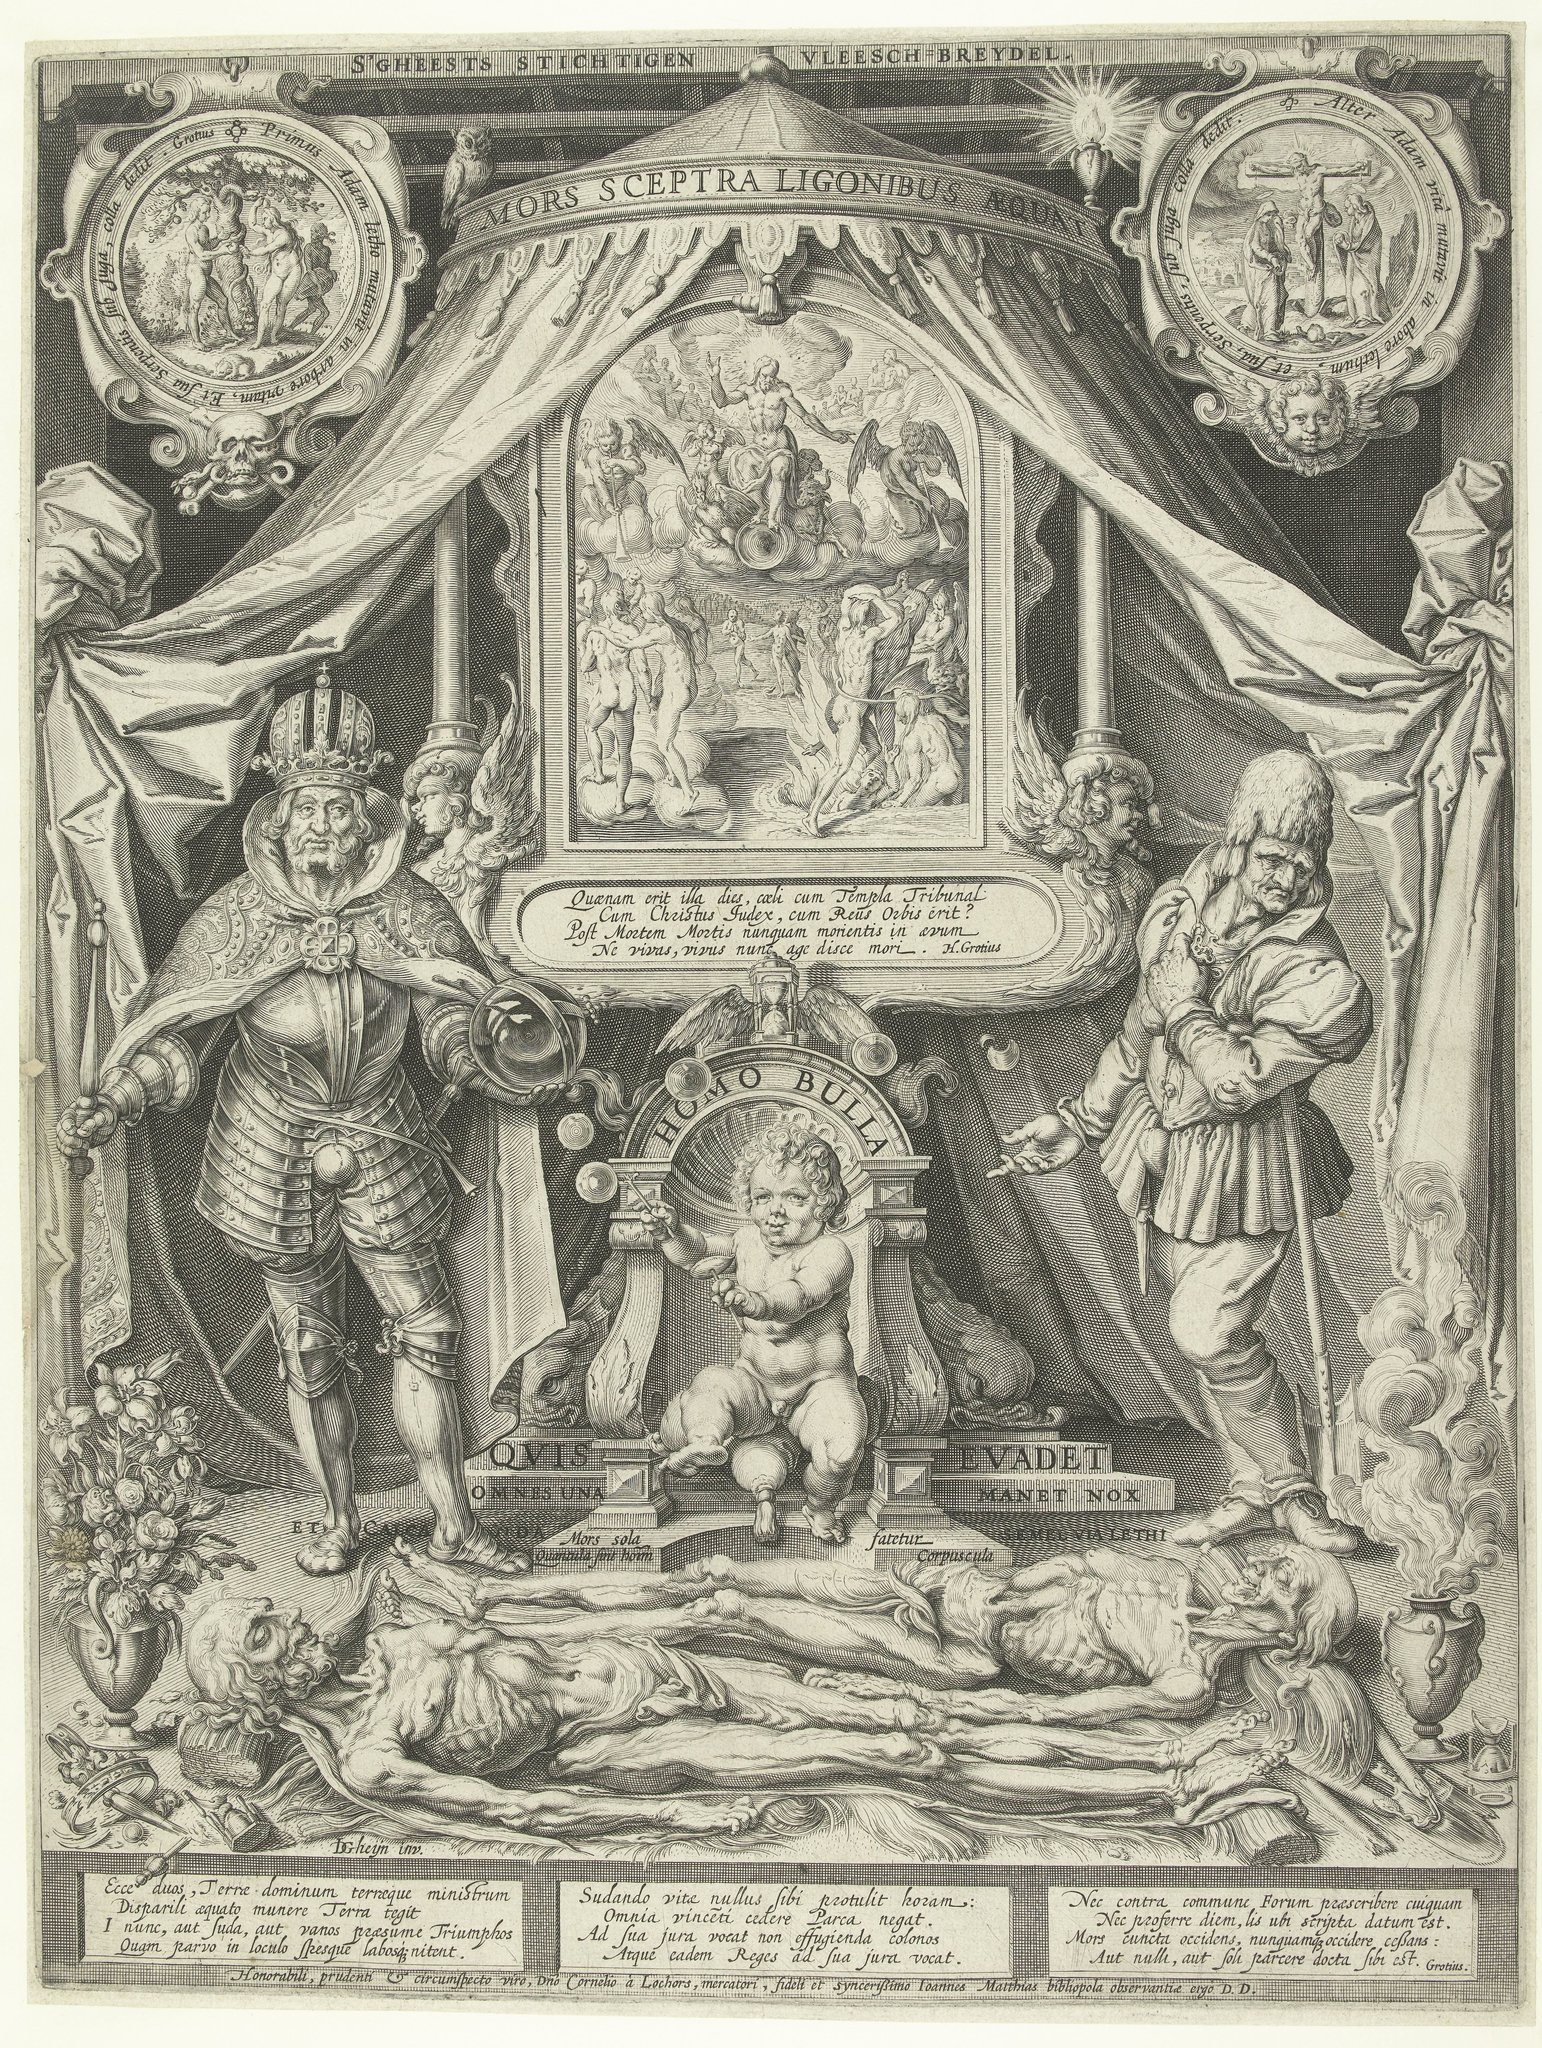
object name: print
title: Allegorie op de dood en de vergankelijkheid van het leven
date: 1599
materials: paper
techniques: engraving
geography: netherlands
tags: eve offers the fruit to adam, comprehensive representation of last judgement: christ (with sword and lily), often surrounded by elders and sometimes accompanied by mary and john the baptist, appears in the sky with trumpeting angels (and sometimes angels holding the instruments of the passion); after the resurrection of the dead the blessed are led to heaven by angels, and the damned are dragged into hell by devils, farmers, 'vanitas' symbols, emperor, hourglass, the corpse, crucified christ with mary and john on either side of the cross; holy rood, smoking pot as symbol of 'vanitas', (children or putti) blowing bubbles, 'homo bulla' ~ scene symbolizing 'vanitas'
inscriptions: collector's mark: Lugt 2228a